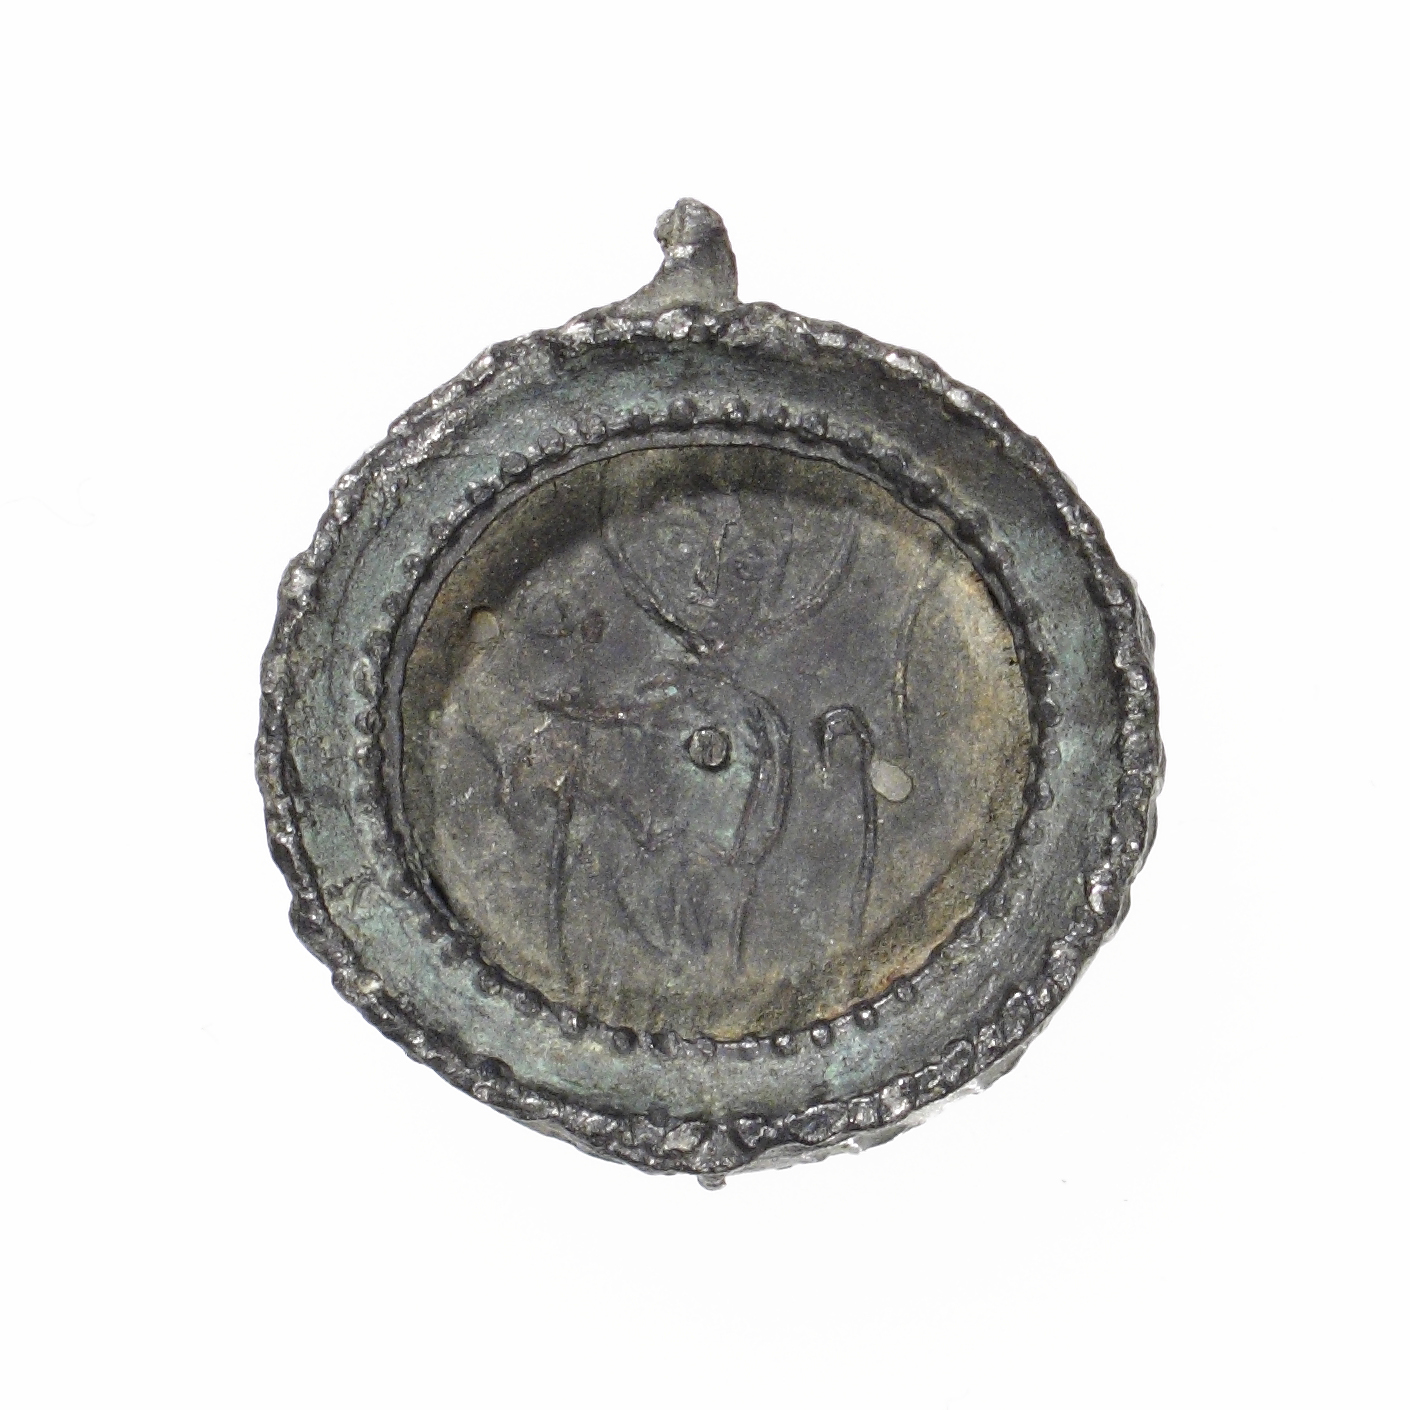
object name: pilgrim's badge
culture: french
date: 1301-1600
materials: lead